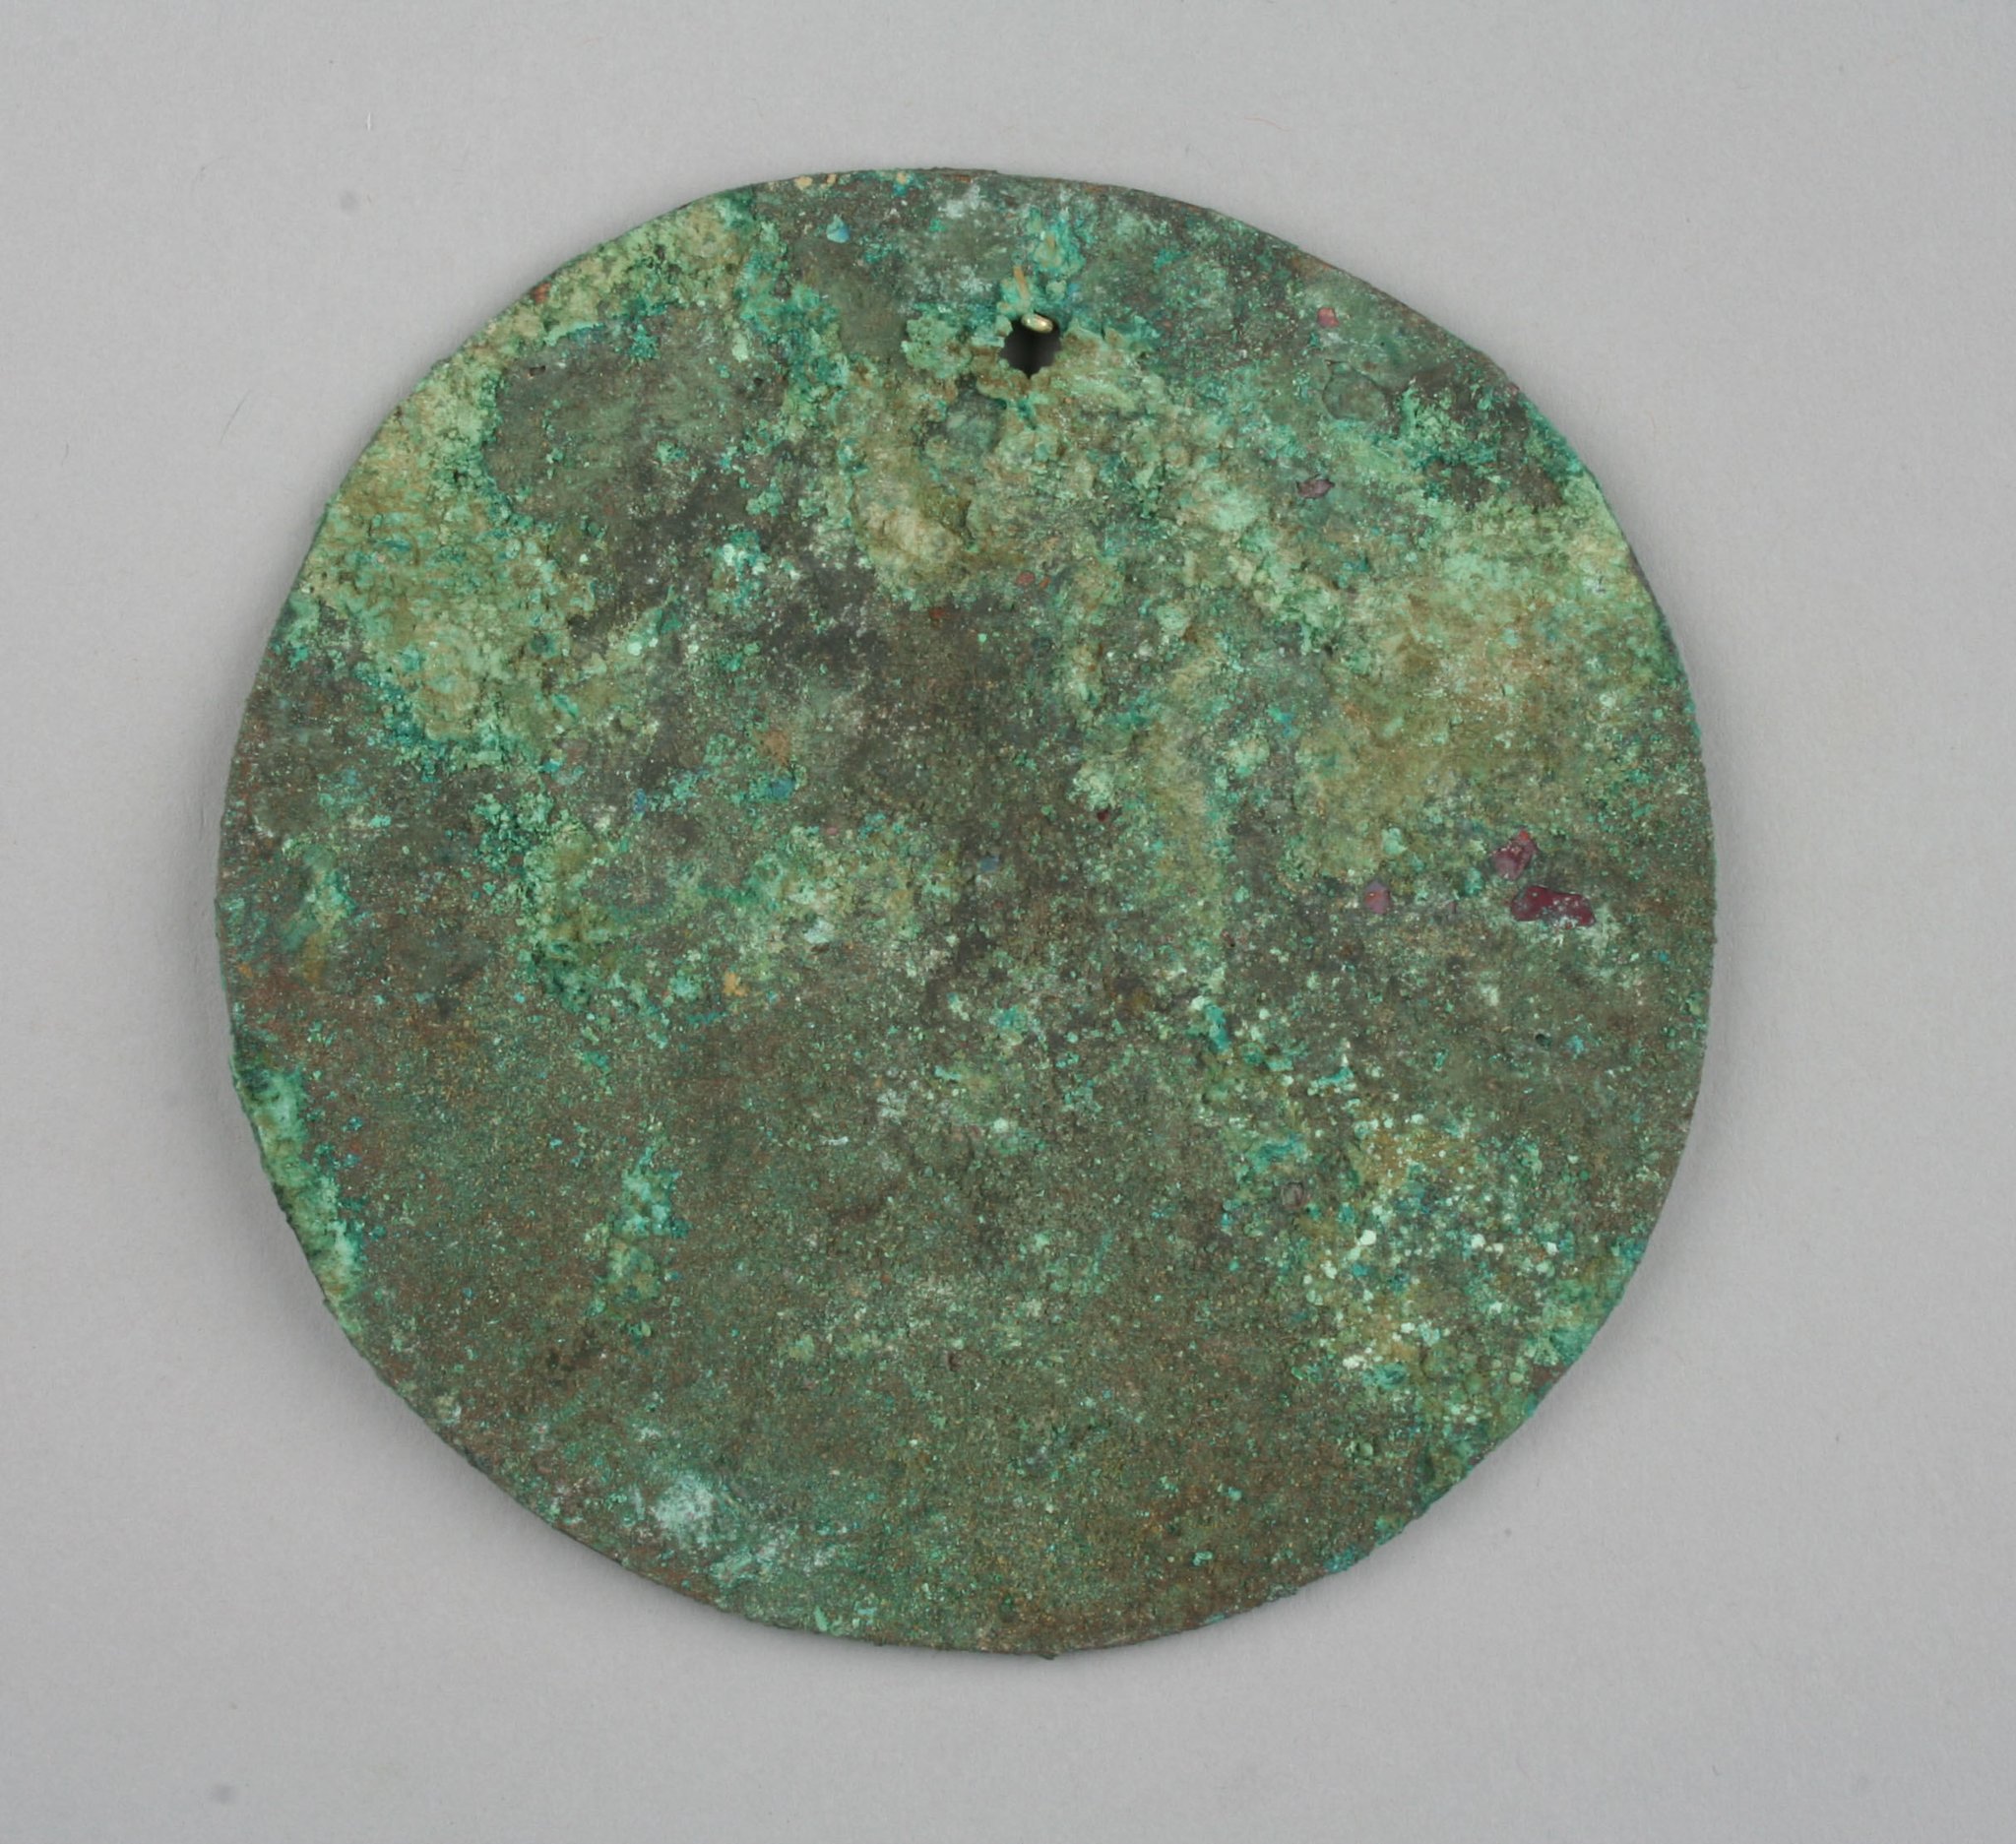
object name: plaque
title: Round Plaque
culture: vicús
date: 300 BCE-200 CE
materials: copper, gilt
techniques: hammering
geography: peru